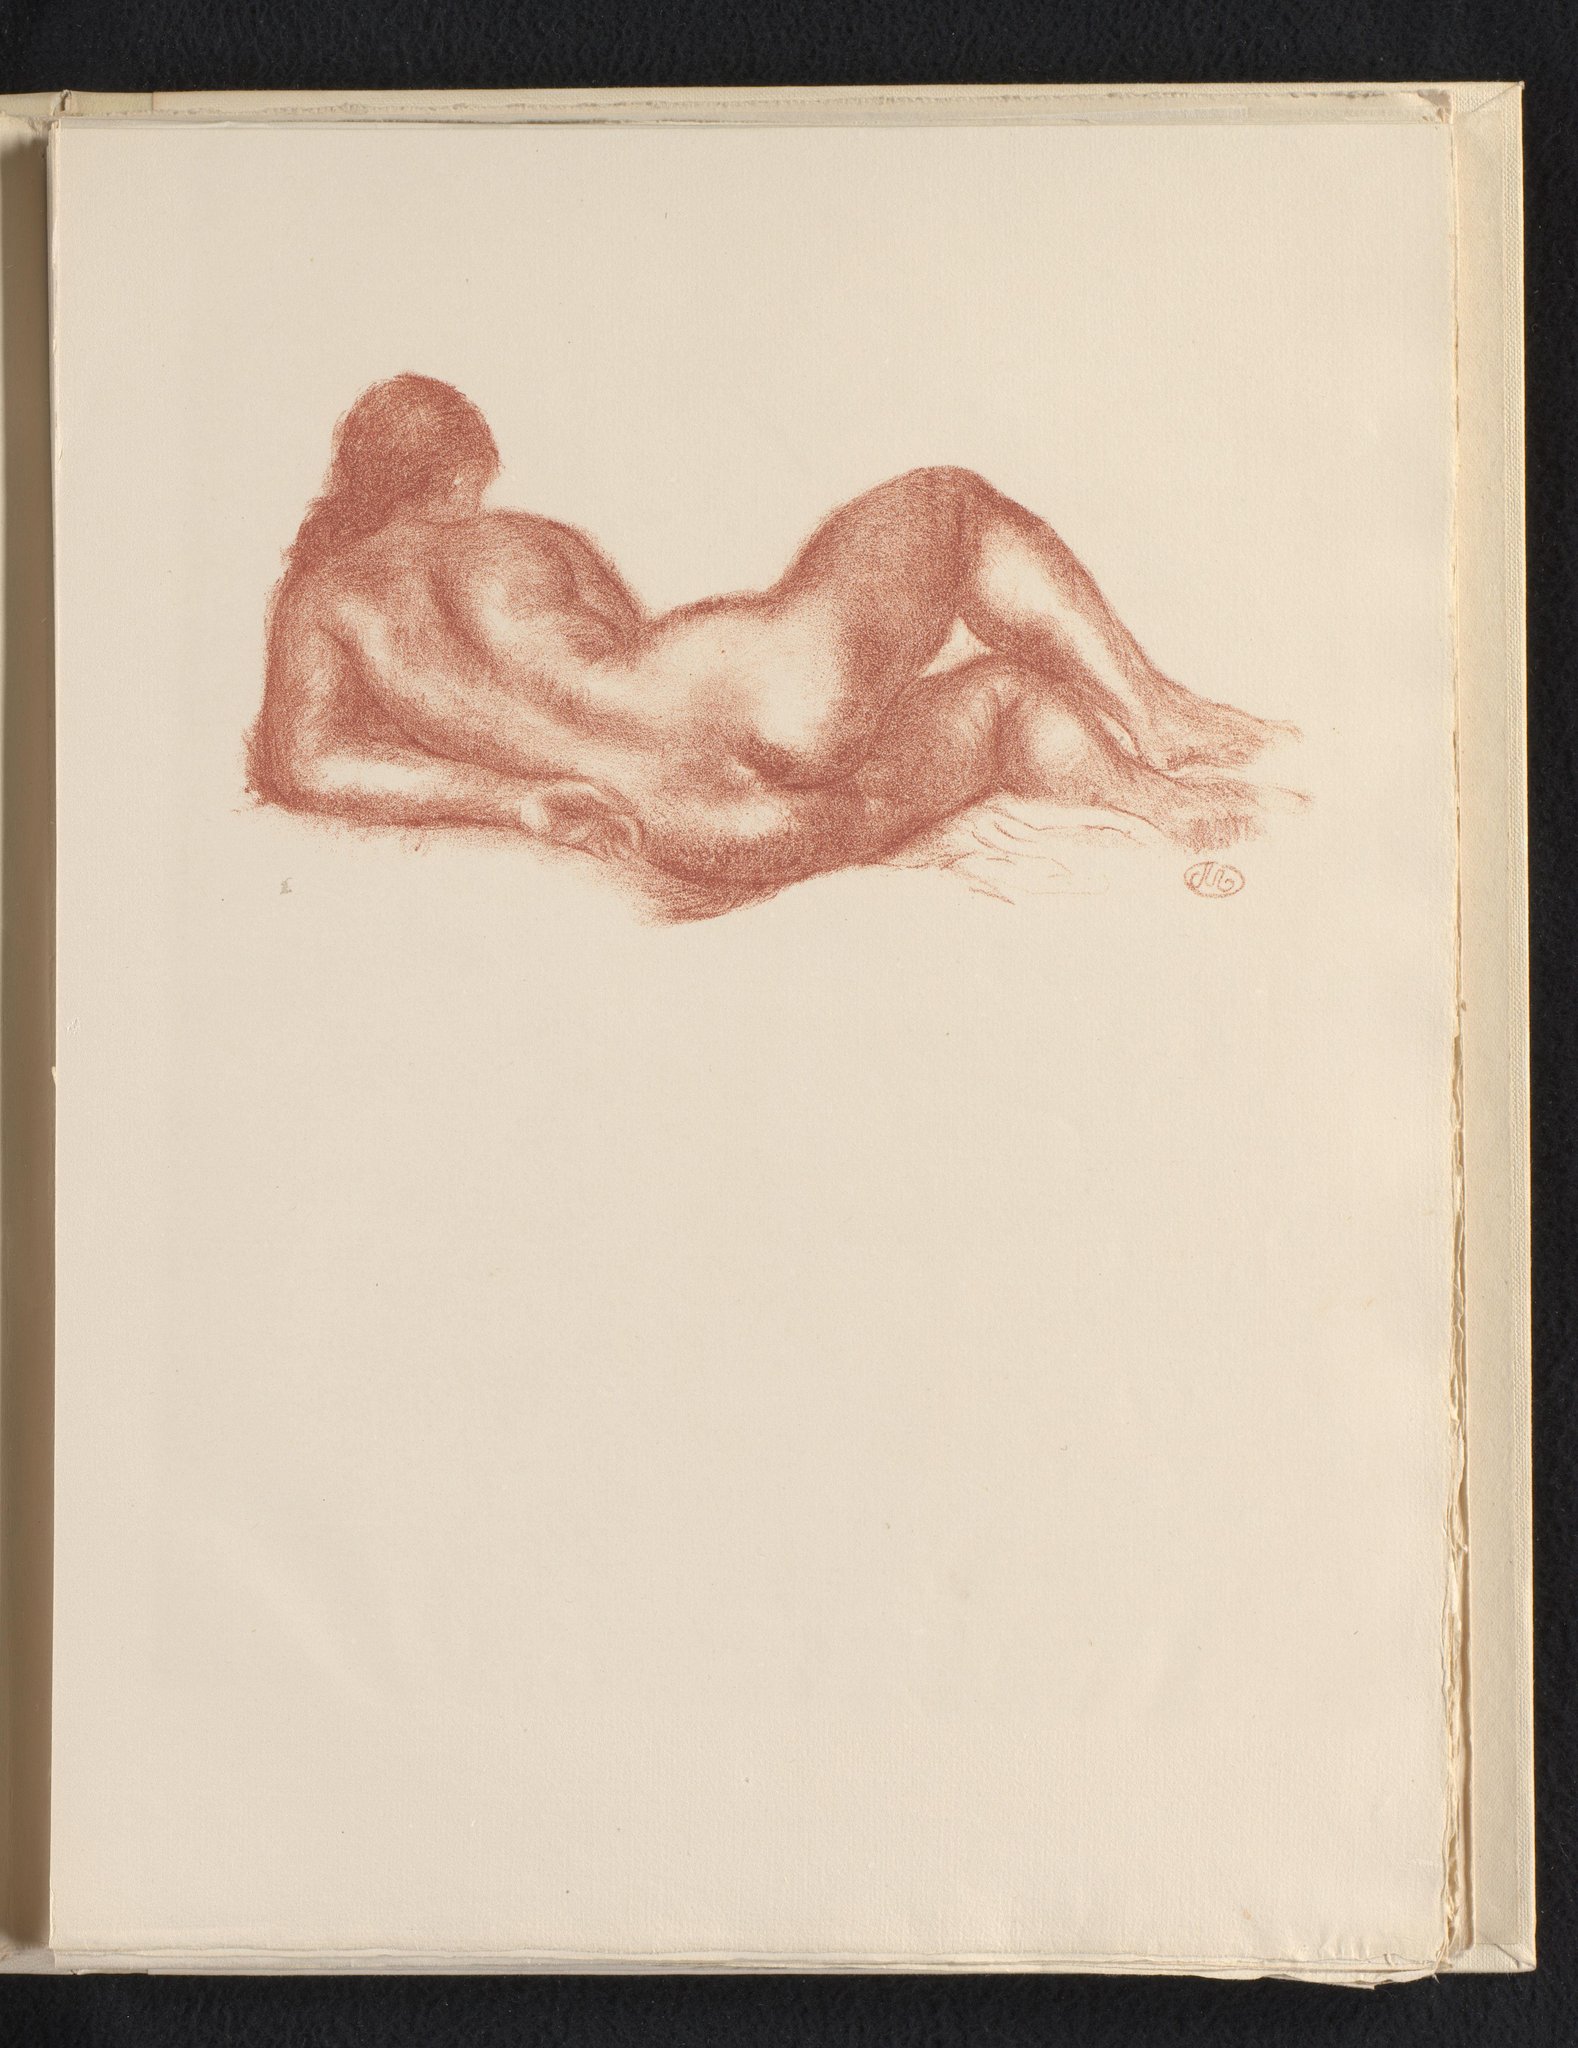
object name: book illustration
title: Liggende naakte vrouw, op de rug gezien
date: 1948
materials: paper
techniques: lithograph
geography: paris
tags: lying on one side, with uplifted upper part of the body and leaning on the arm - aa - female human figure, woman (showing herself) undressed, quasi-nude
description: Prent uit: Lucianus van Samosata. Dialogues des Courtisanes. [Vertaald uit het Grieks door] Charles Astruc. Parijs: s.n., 1948, deel van de suite met een extra afdruk van de prenten in sanguine.